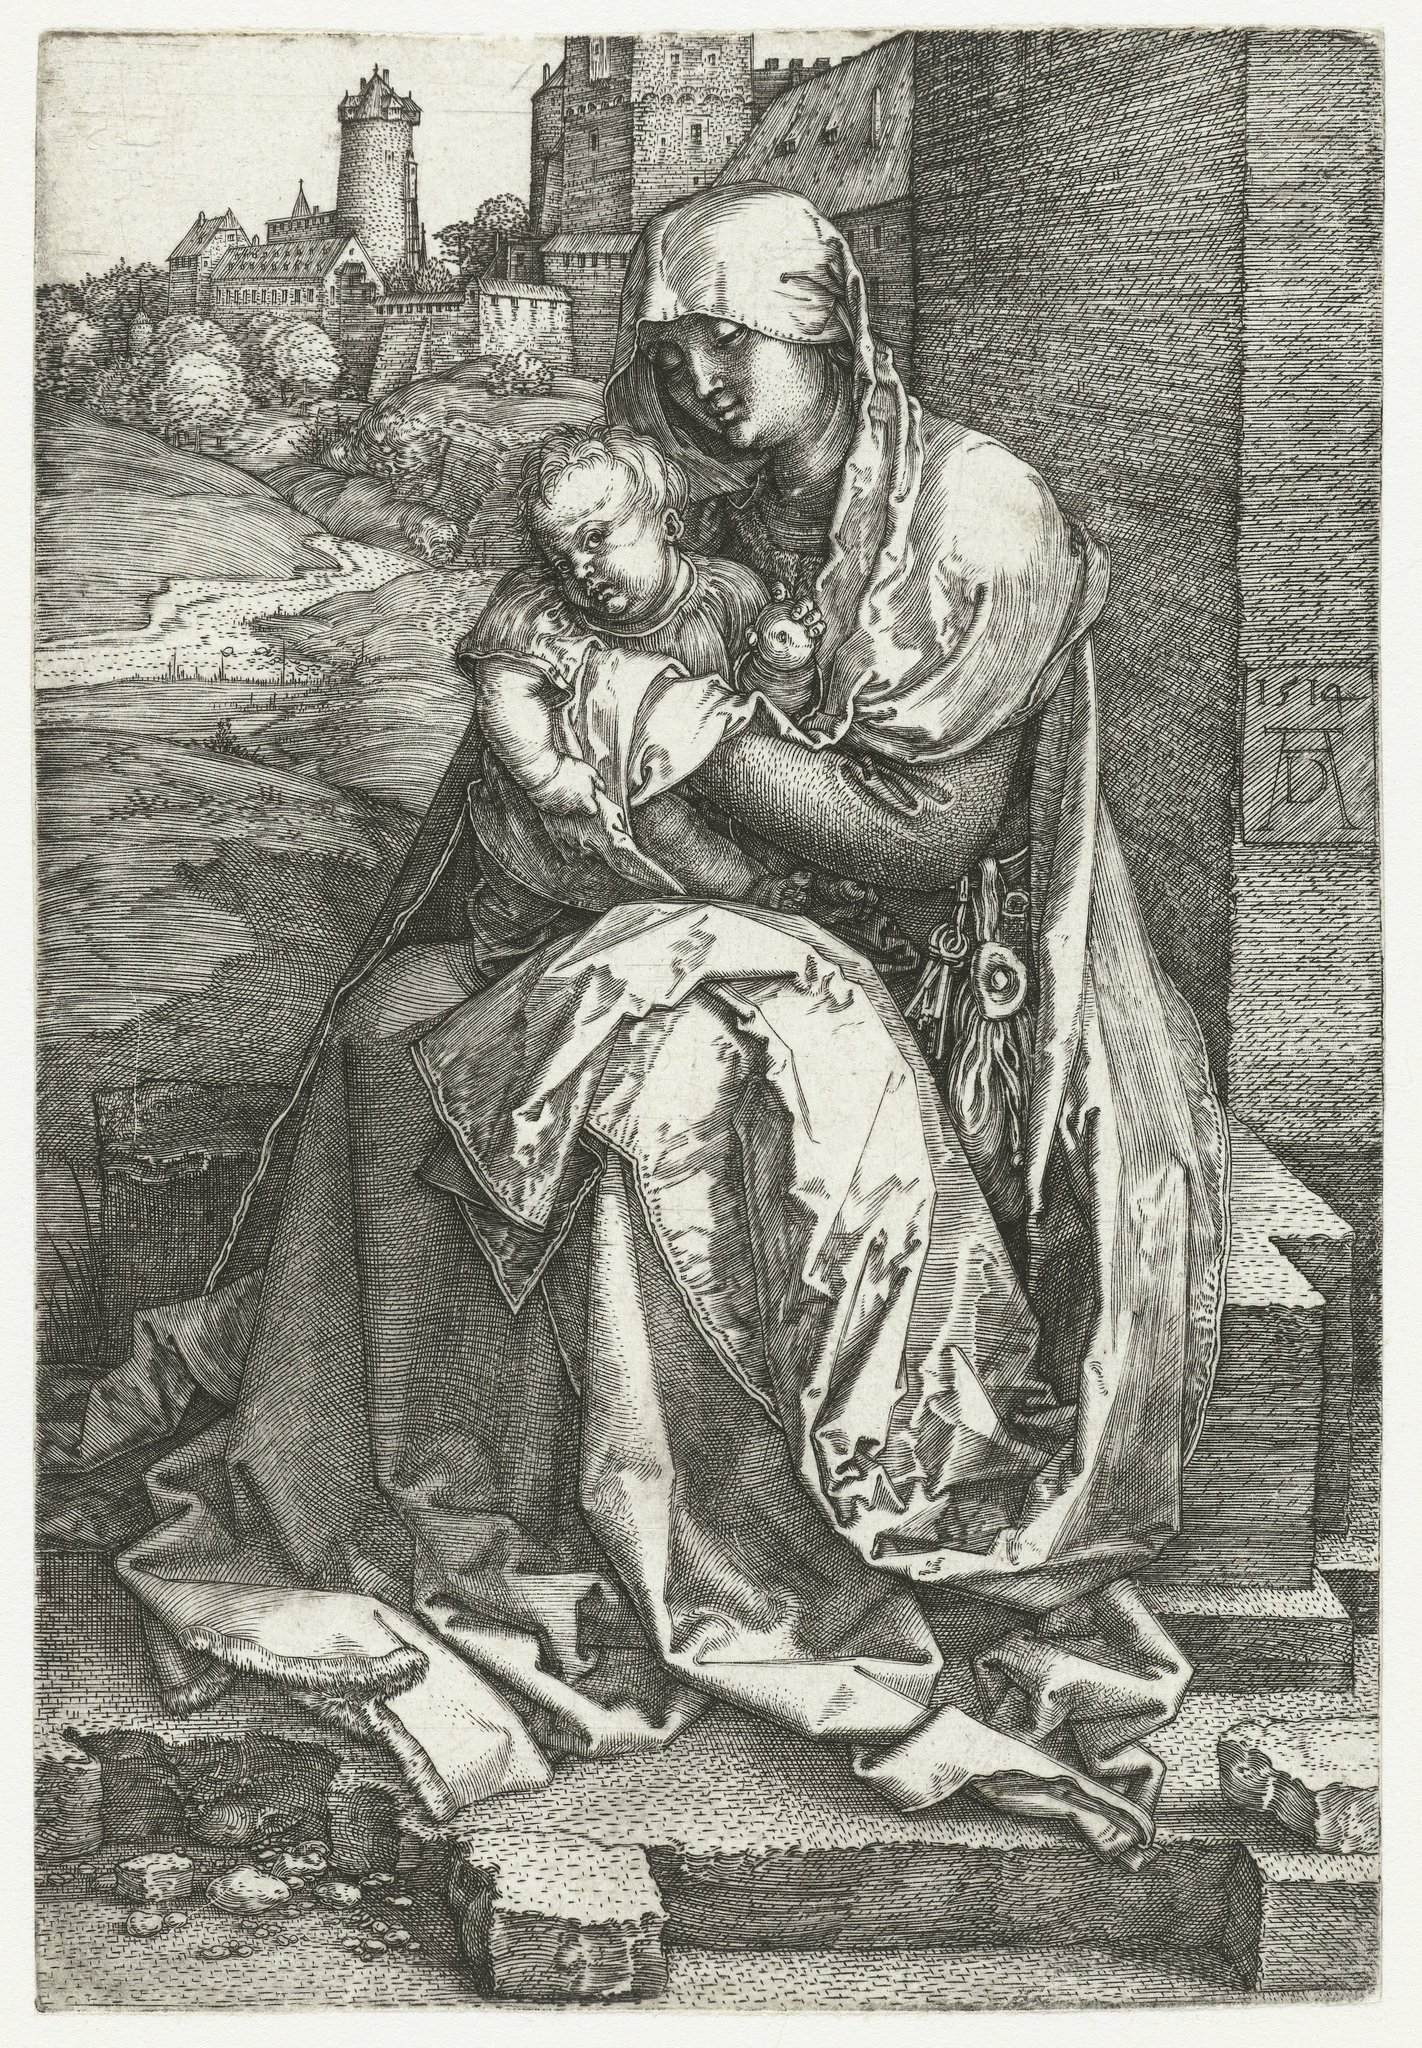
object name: print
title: Maria met kind bij een muur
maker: albrecht dürer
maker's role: draughtsman, painter, print maker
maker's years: 1471-1528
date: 1514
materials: paper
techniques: engraving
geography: nuremberg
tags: mary sitting or enthroned, the christ-child in front of her in her lap (or in front of her bosom)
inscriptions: collector's mark: Lugt 240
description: Mogelijk had deze prent oorspronkelijk het inventarisnummer RP-P-1877-A-34 (zie opmerking aldaar). Klinkert, C.